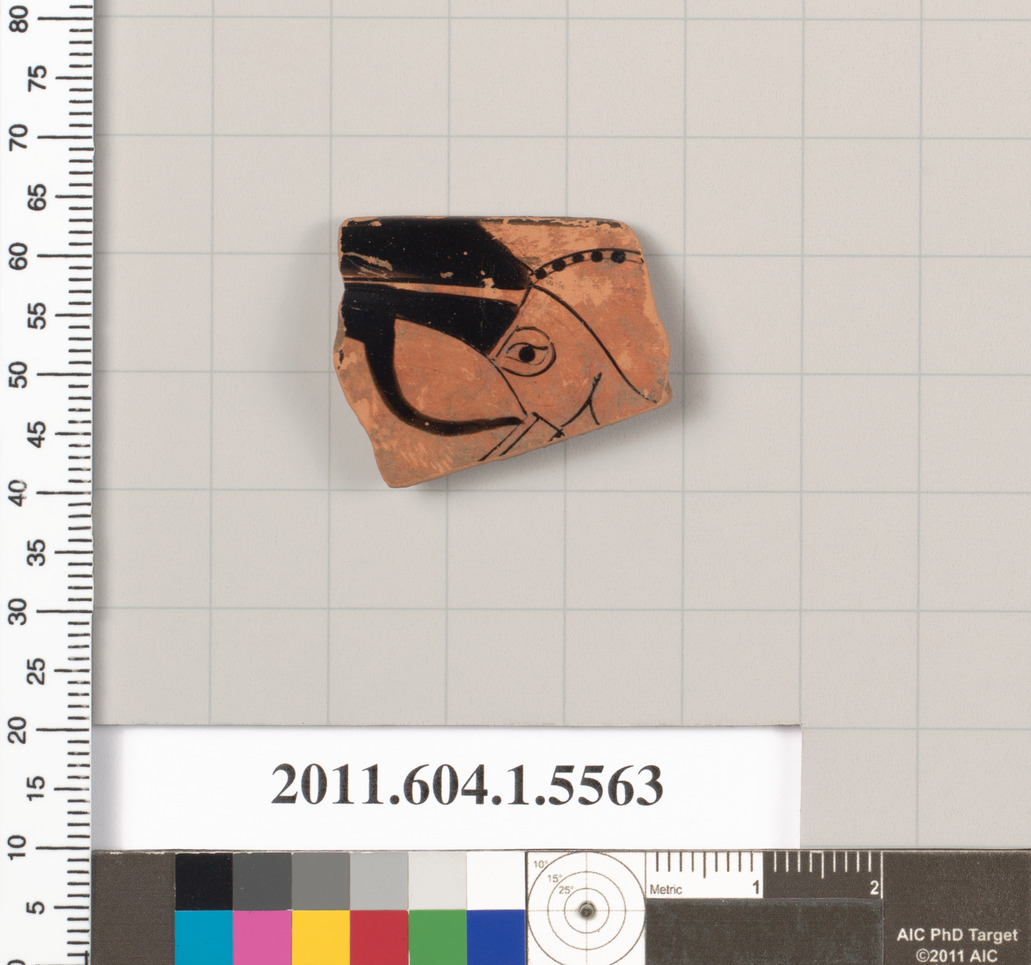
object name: kylix fragment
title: Terracotta rim fragment of a kylix (drinking cup)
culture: greek, attic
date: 520-510 BCE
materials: terracotta